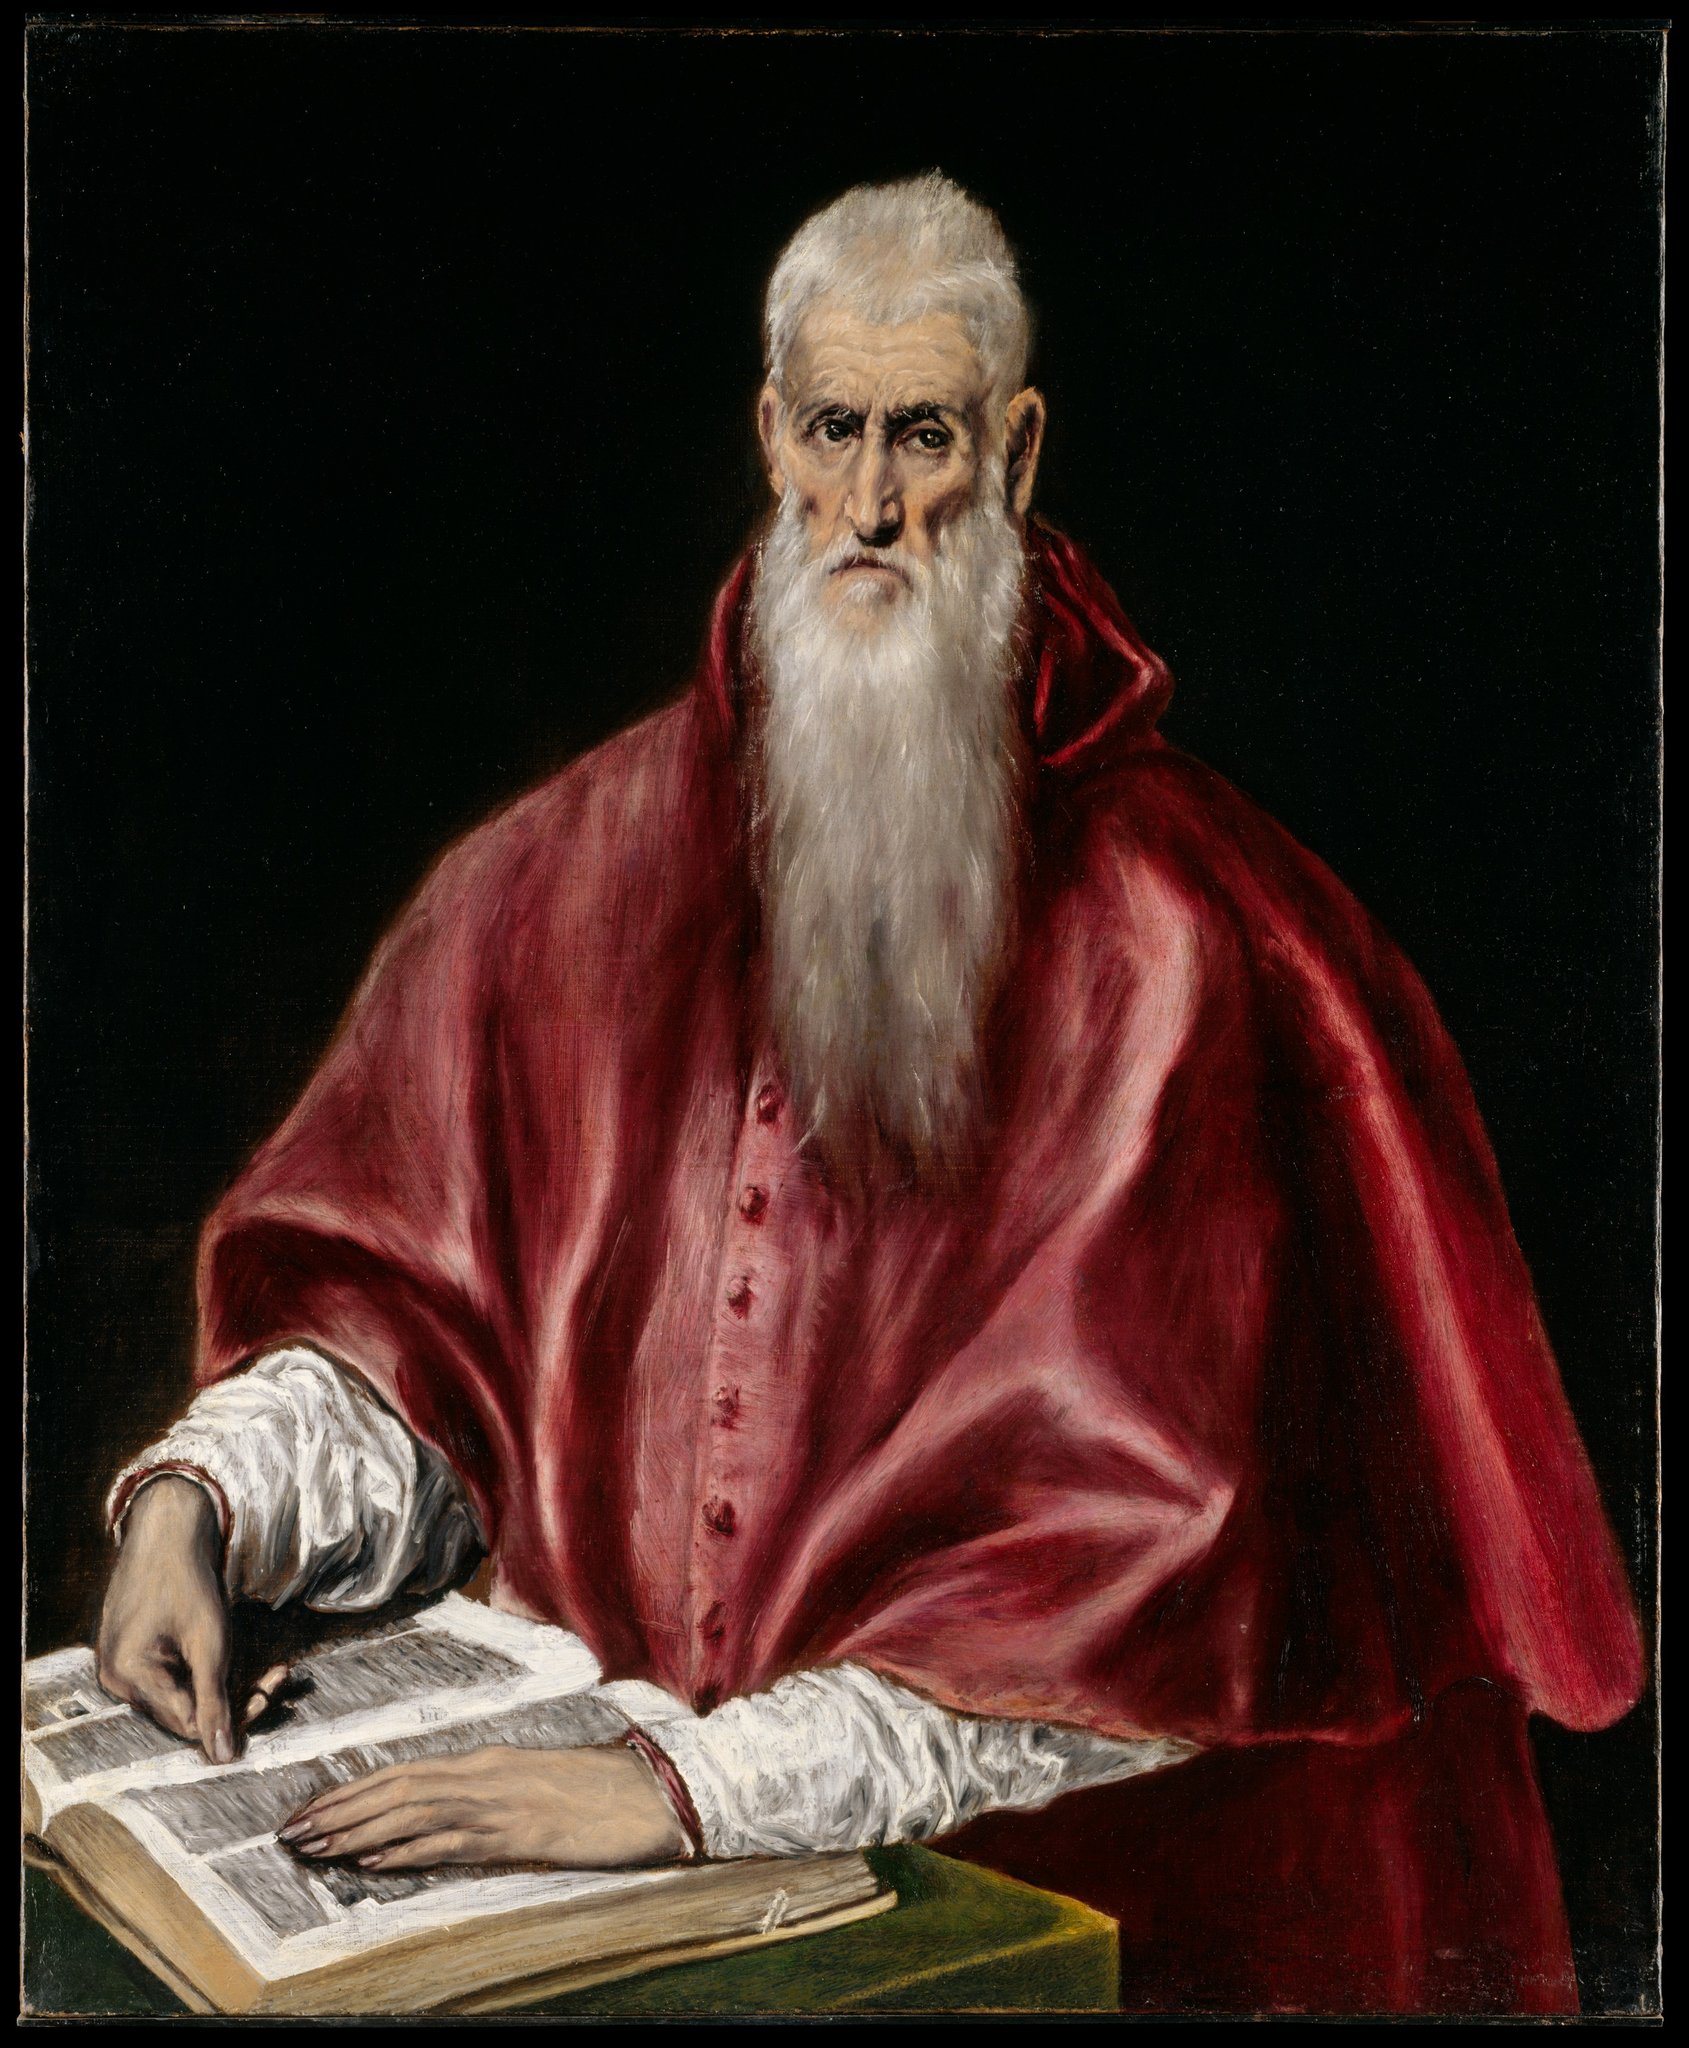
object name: painting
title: Saint Jerome as Scholar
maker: el greco (domenikos theotokopoulos)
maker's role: artist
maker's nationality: greek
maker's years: 1540-1614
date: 1610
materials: canvas, oil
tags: men,saint jerome